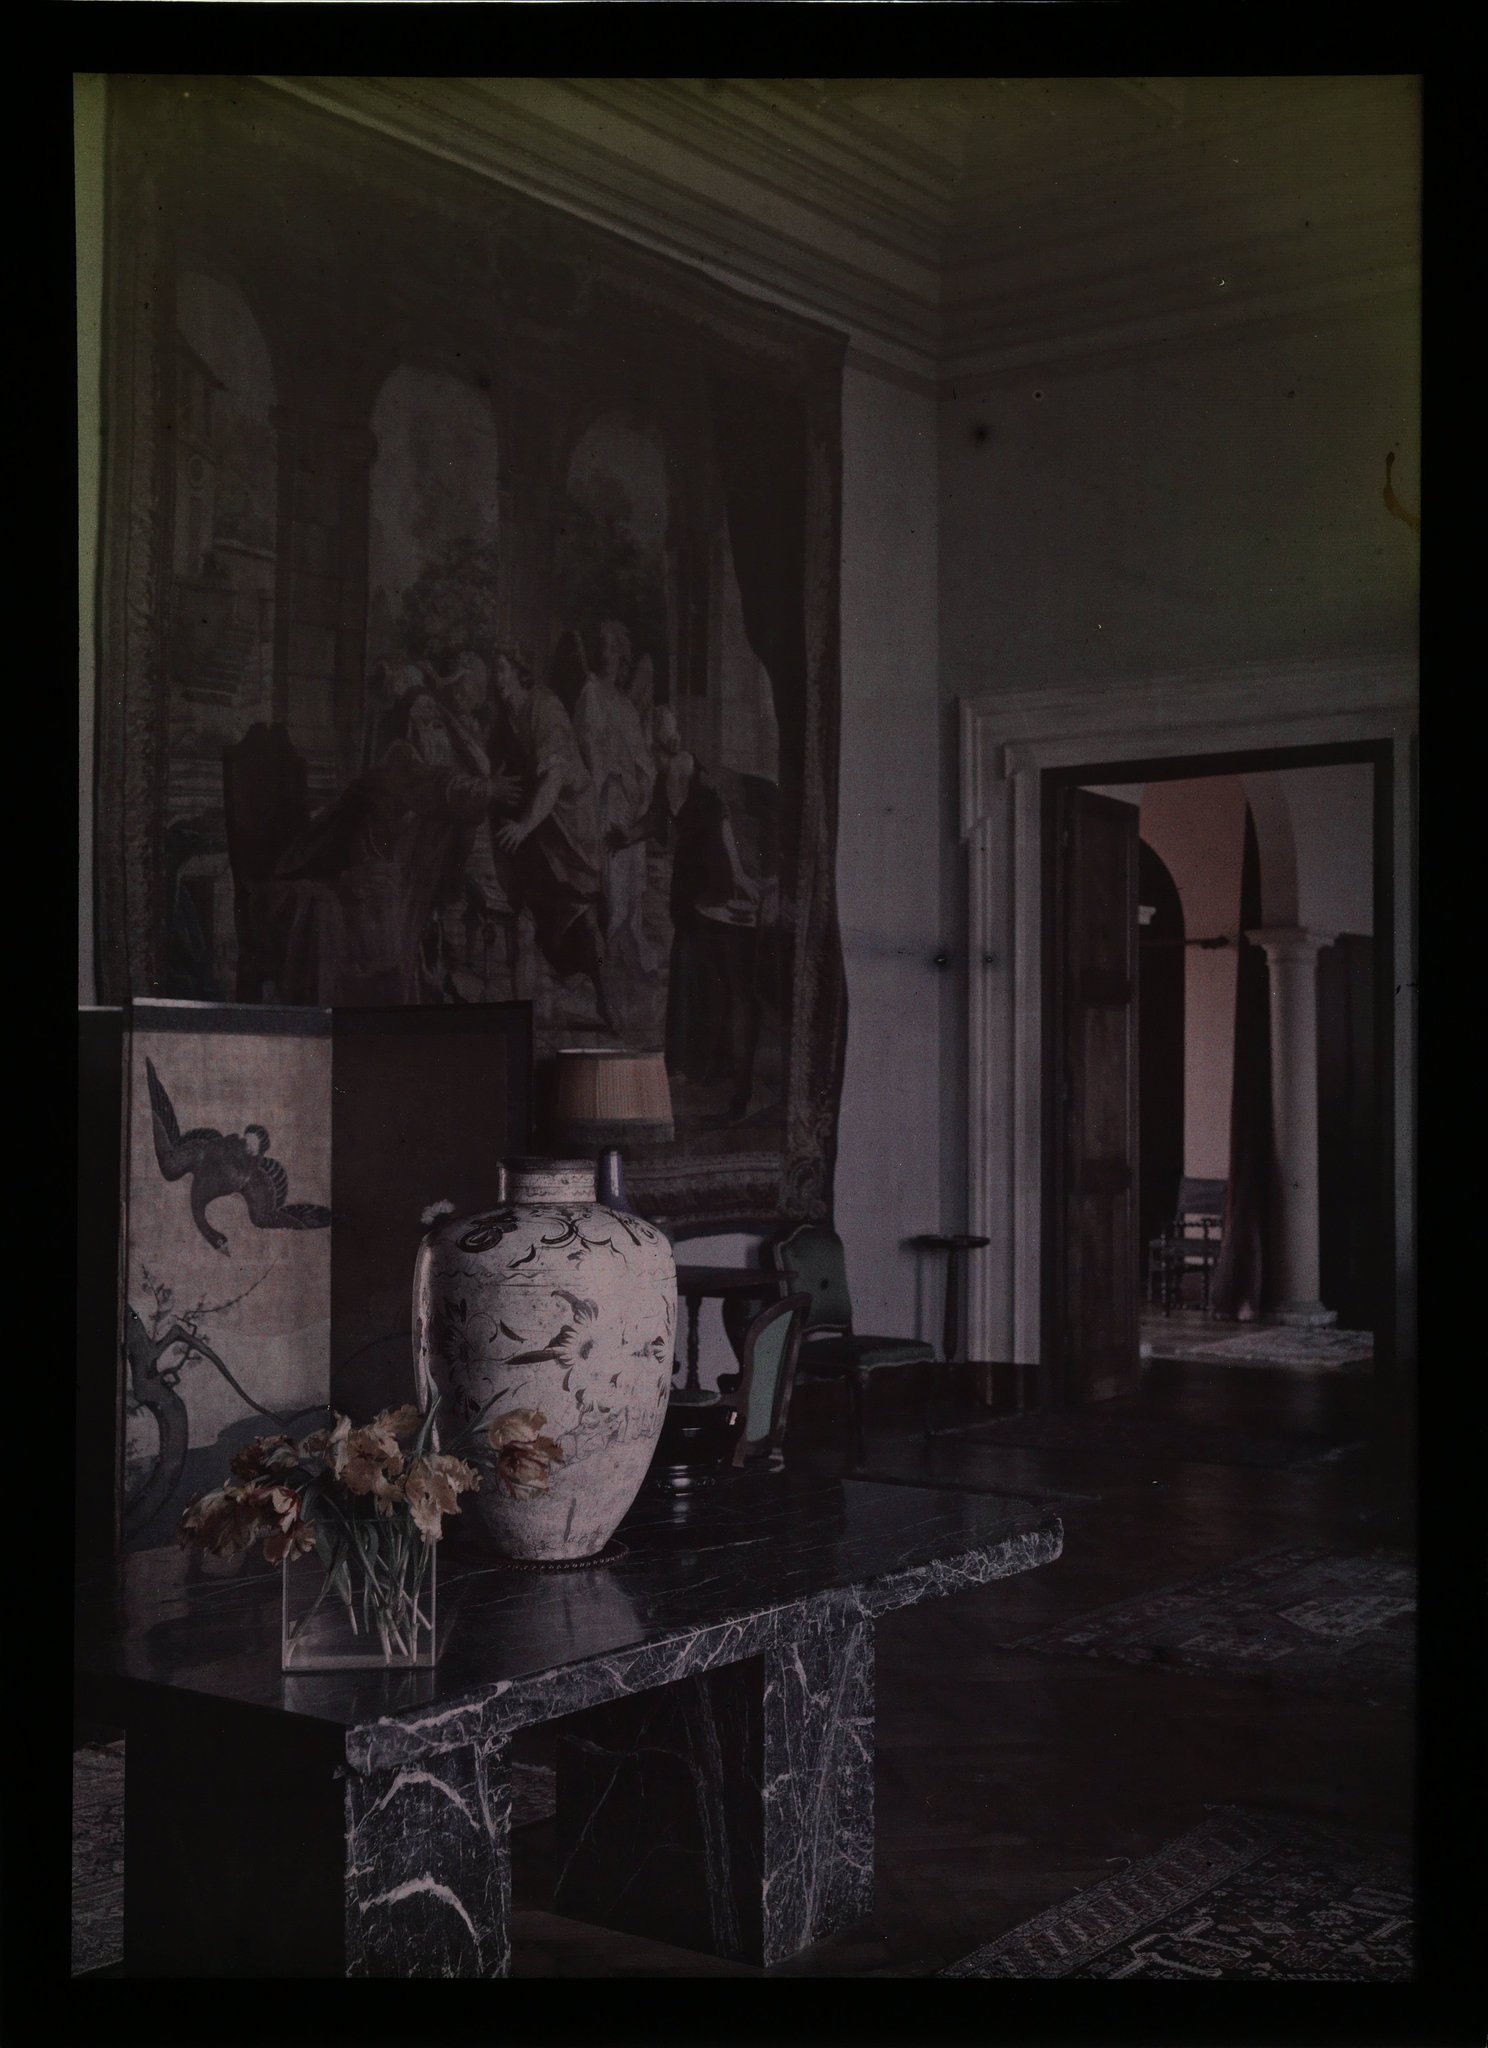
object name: photograph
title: Interieur van een huis met diverse kunstobjecten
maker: Anonymous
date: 1910-1940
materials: glass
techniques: autochrome process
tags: interior of the house, container of ceramics: jar, jug, pot, vase